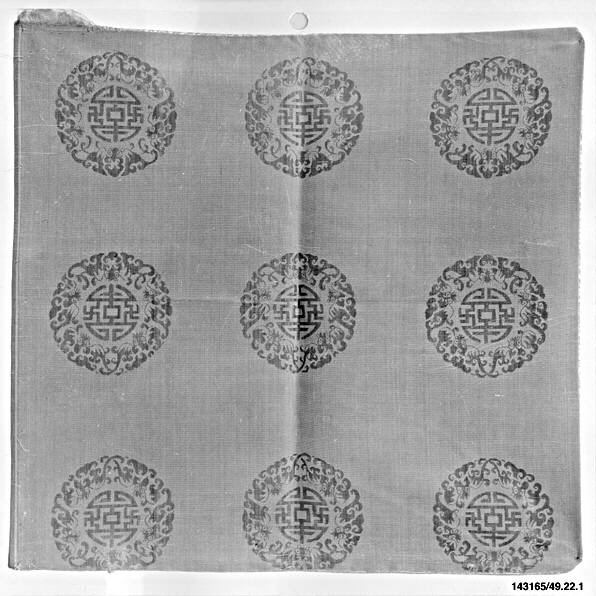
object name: piece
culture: chinese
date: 1901-2000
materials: silk